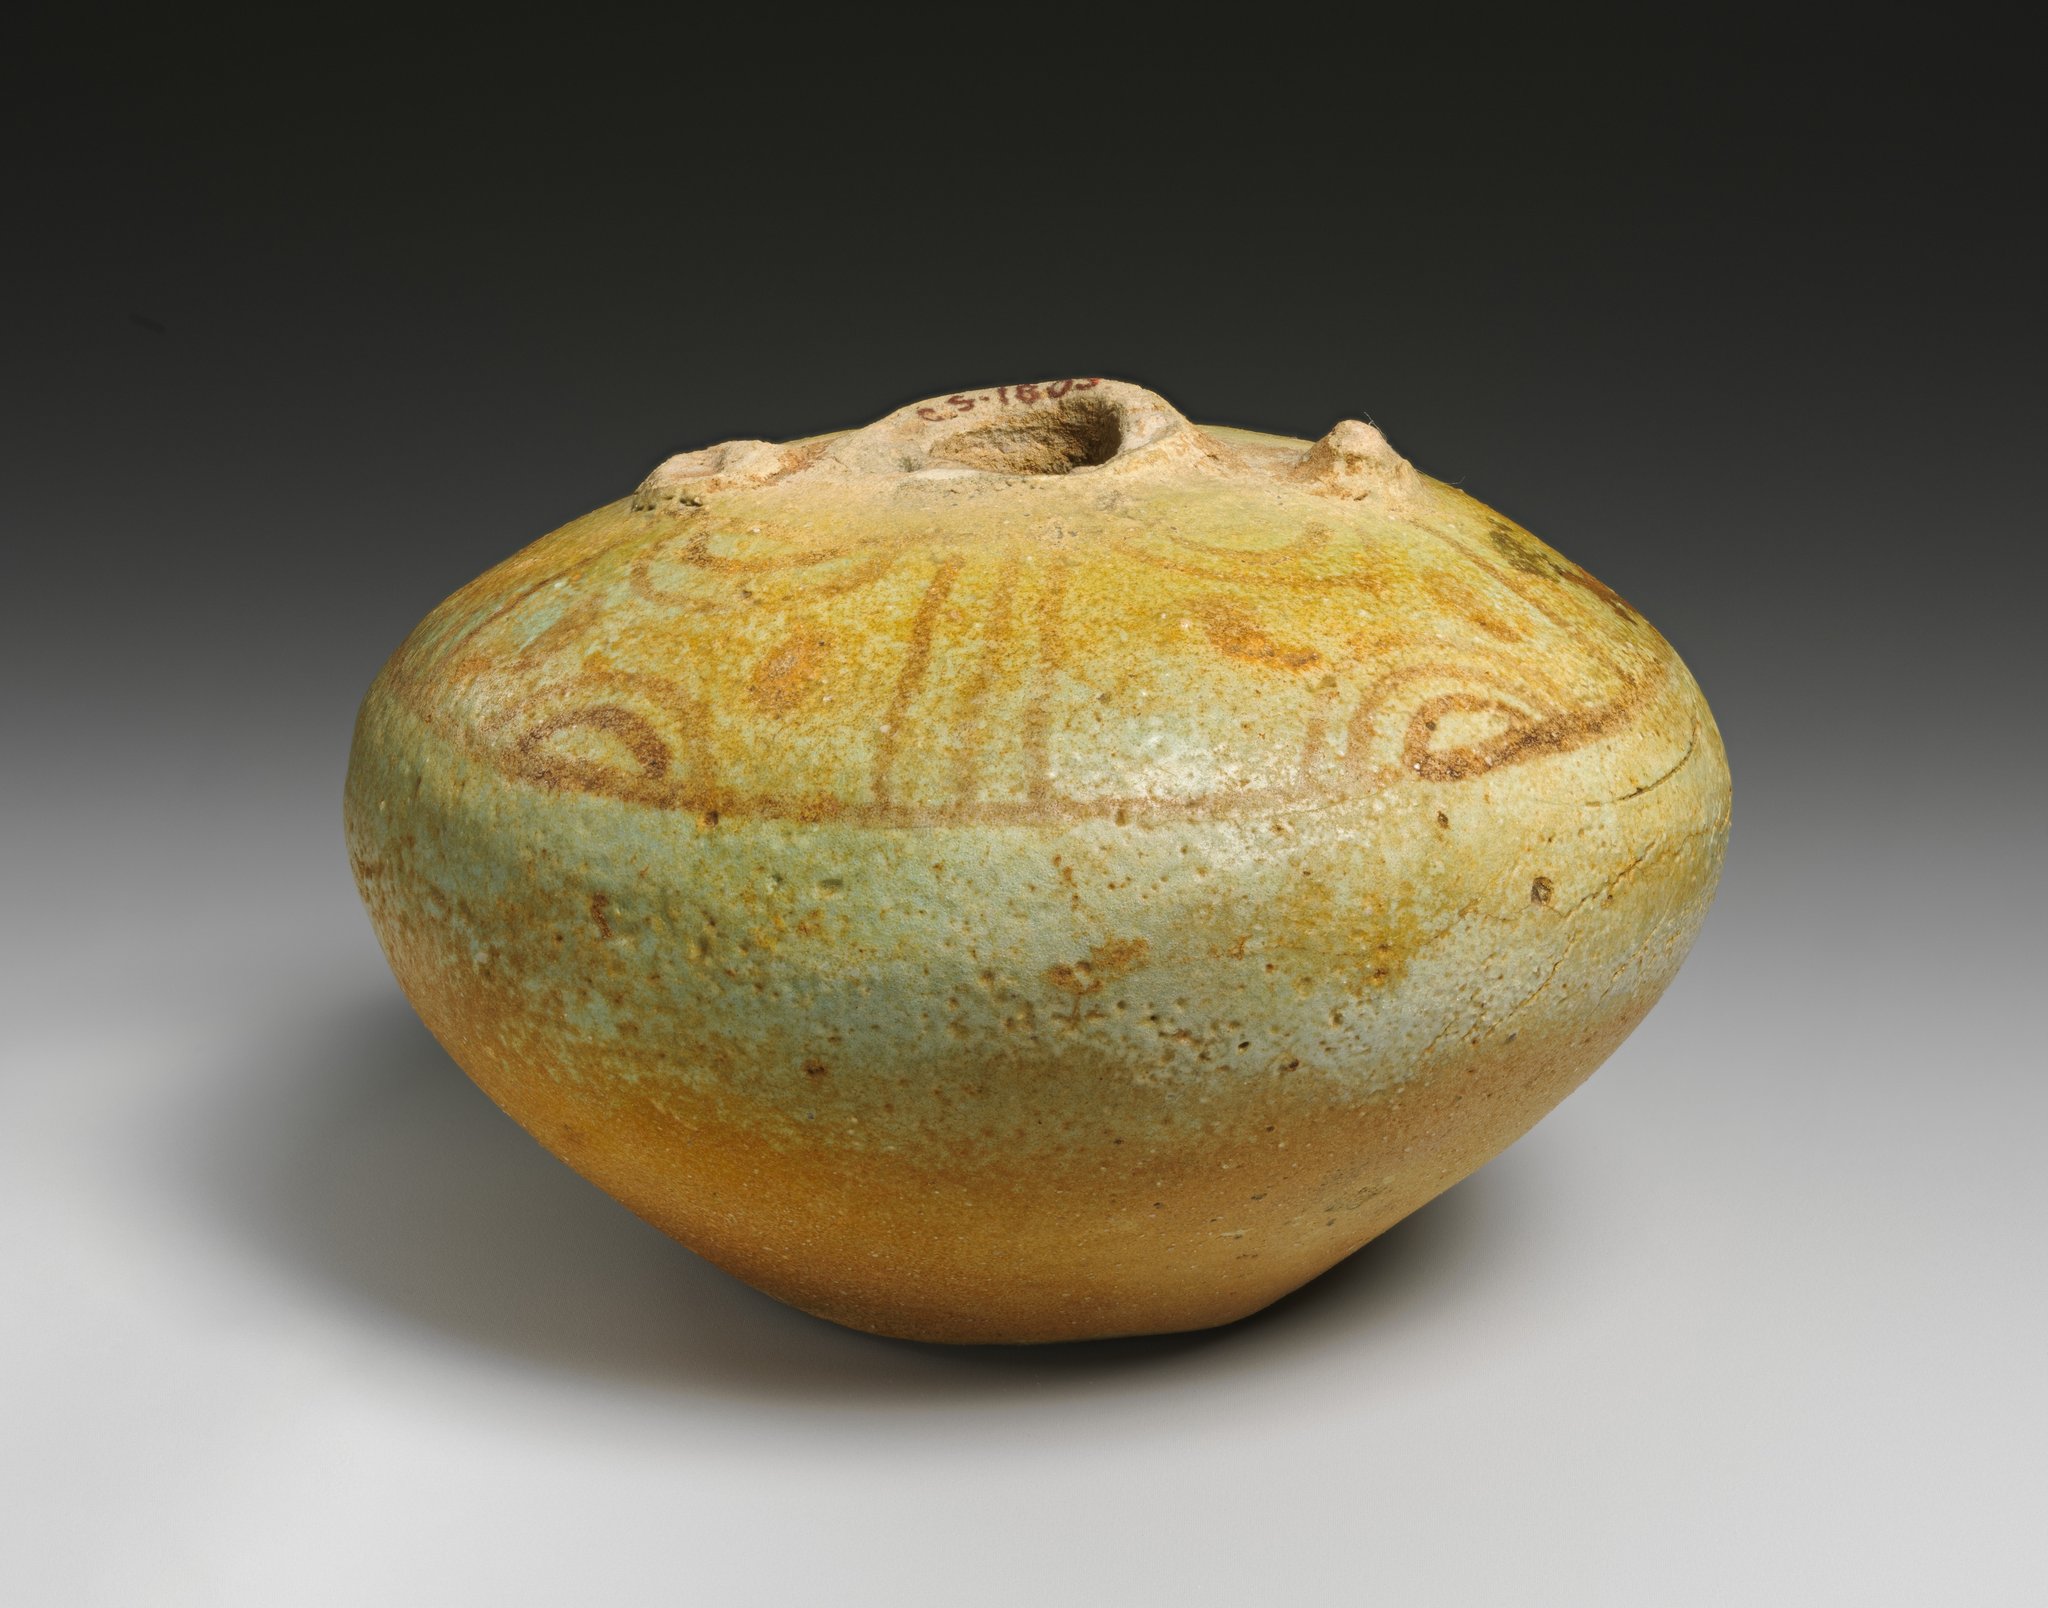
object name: stirrup jar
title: Fragmentary faience stirrup jar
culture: cypriot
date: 1300-1101 BCE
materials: faience